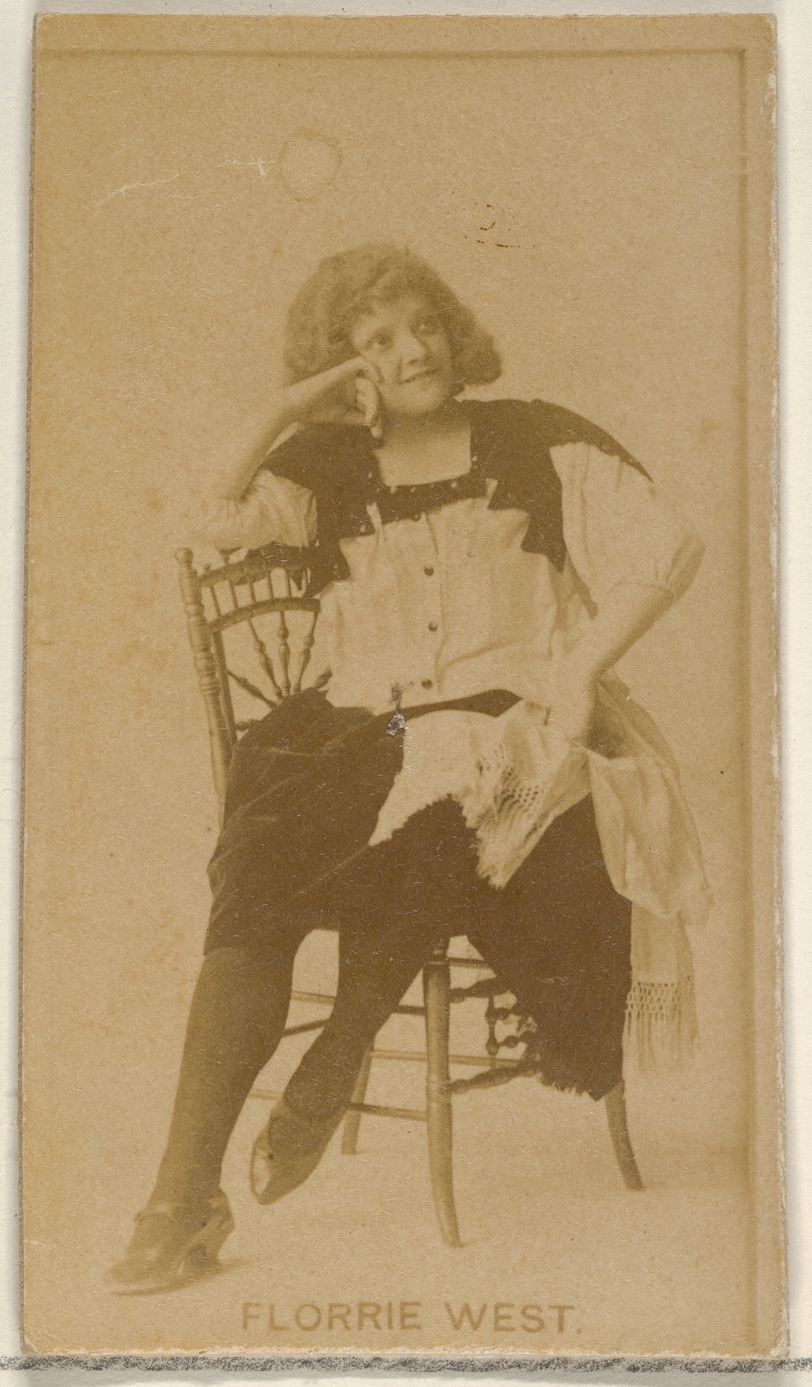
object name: photograph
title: Florrie West, from the Actors and Actresses series (N45, Type 8) for Virginia Brights Cigarettes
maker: allen & ginter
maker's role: publisher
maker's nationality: american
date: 1888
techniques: albumen silver print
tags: portraits,women,actresses